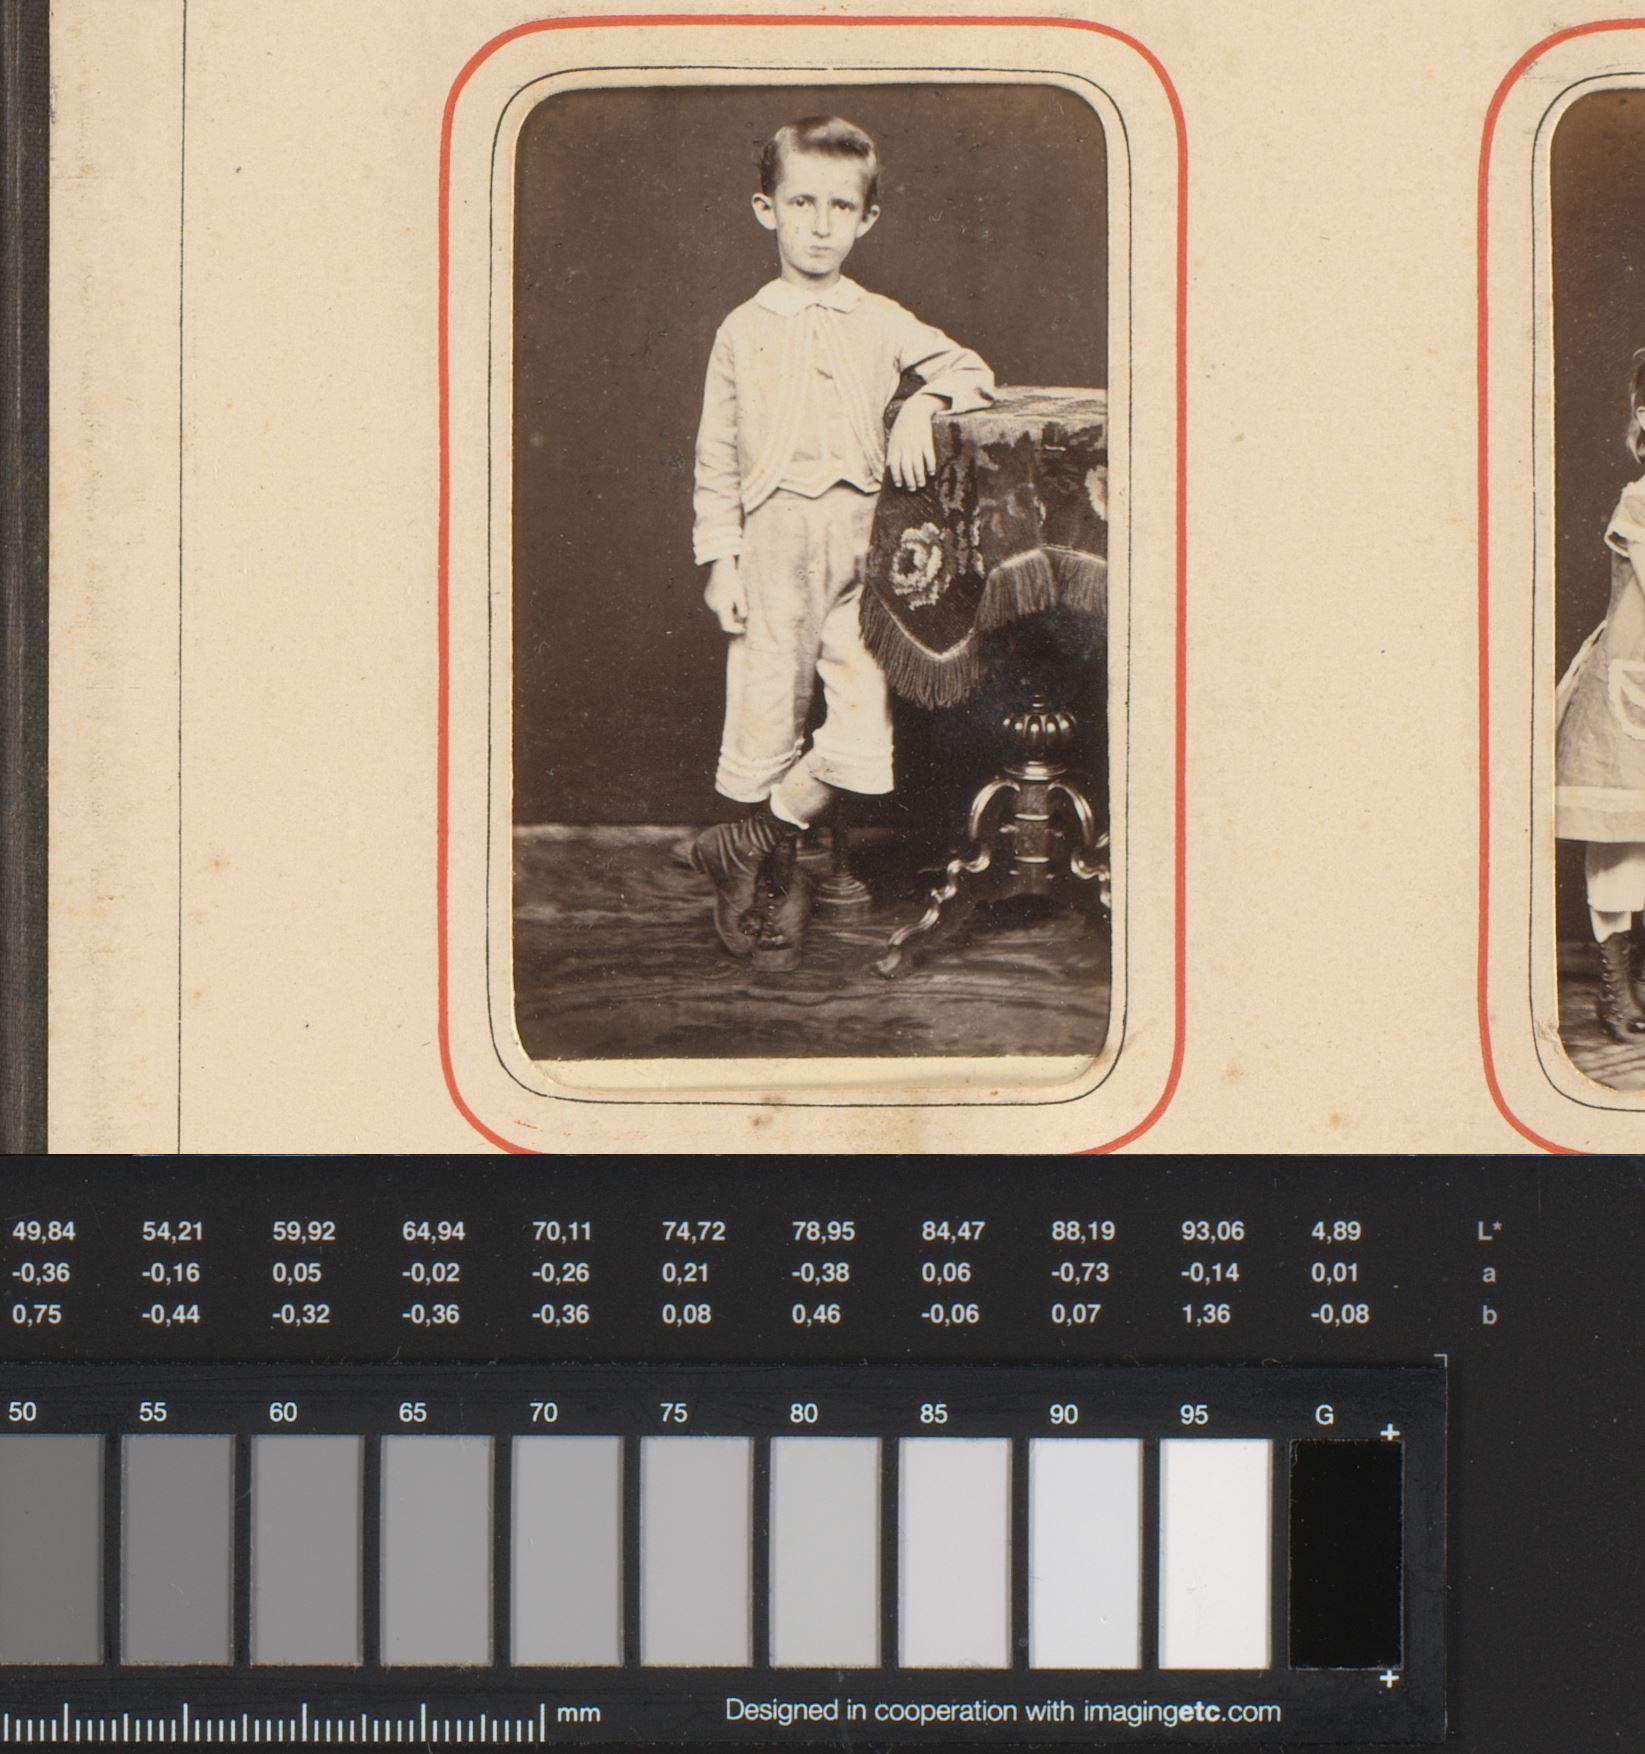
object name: album leaf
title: Portret van een onbekende jongen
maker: j.b. jasper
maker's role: fotograaf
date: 1870-1899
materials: cardboard, paper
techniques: albumen print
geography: surabaya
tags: anonymous historical person portrayed